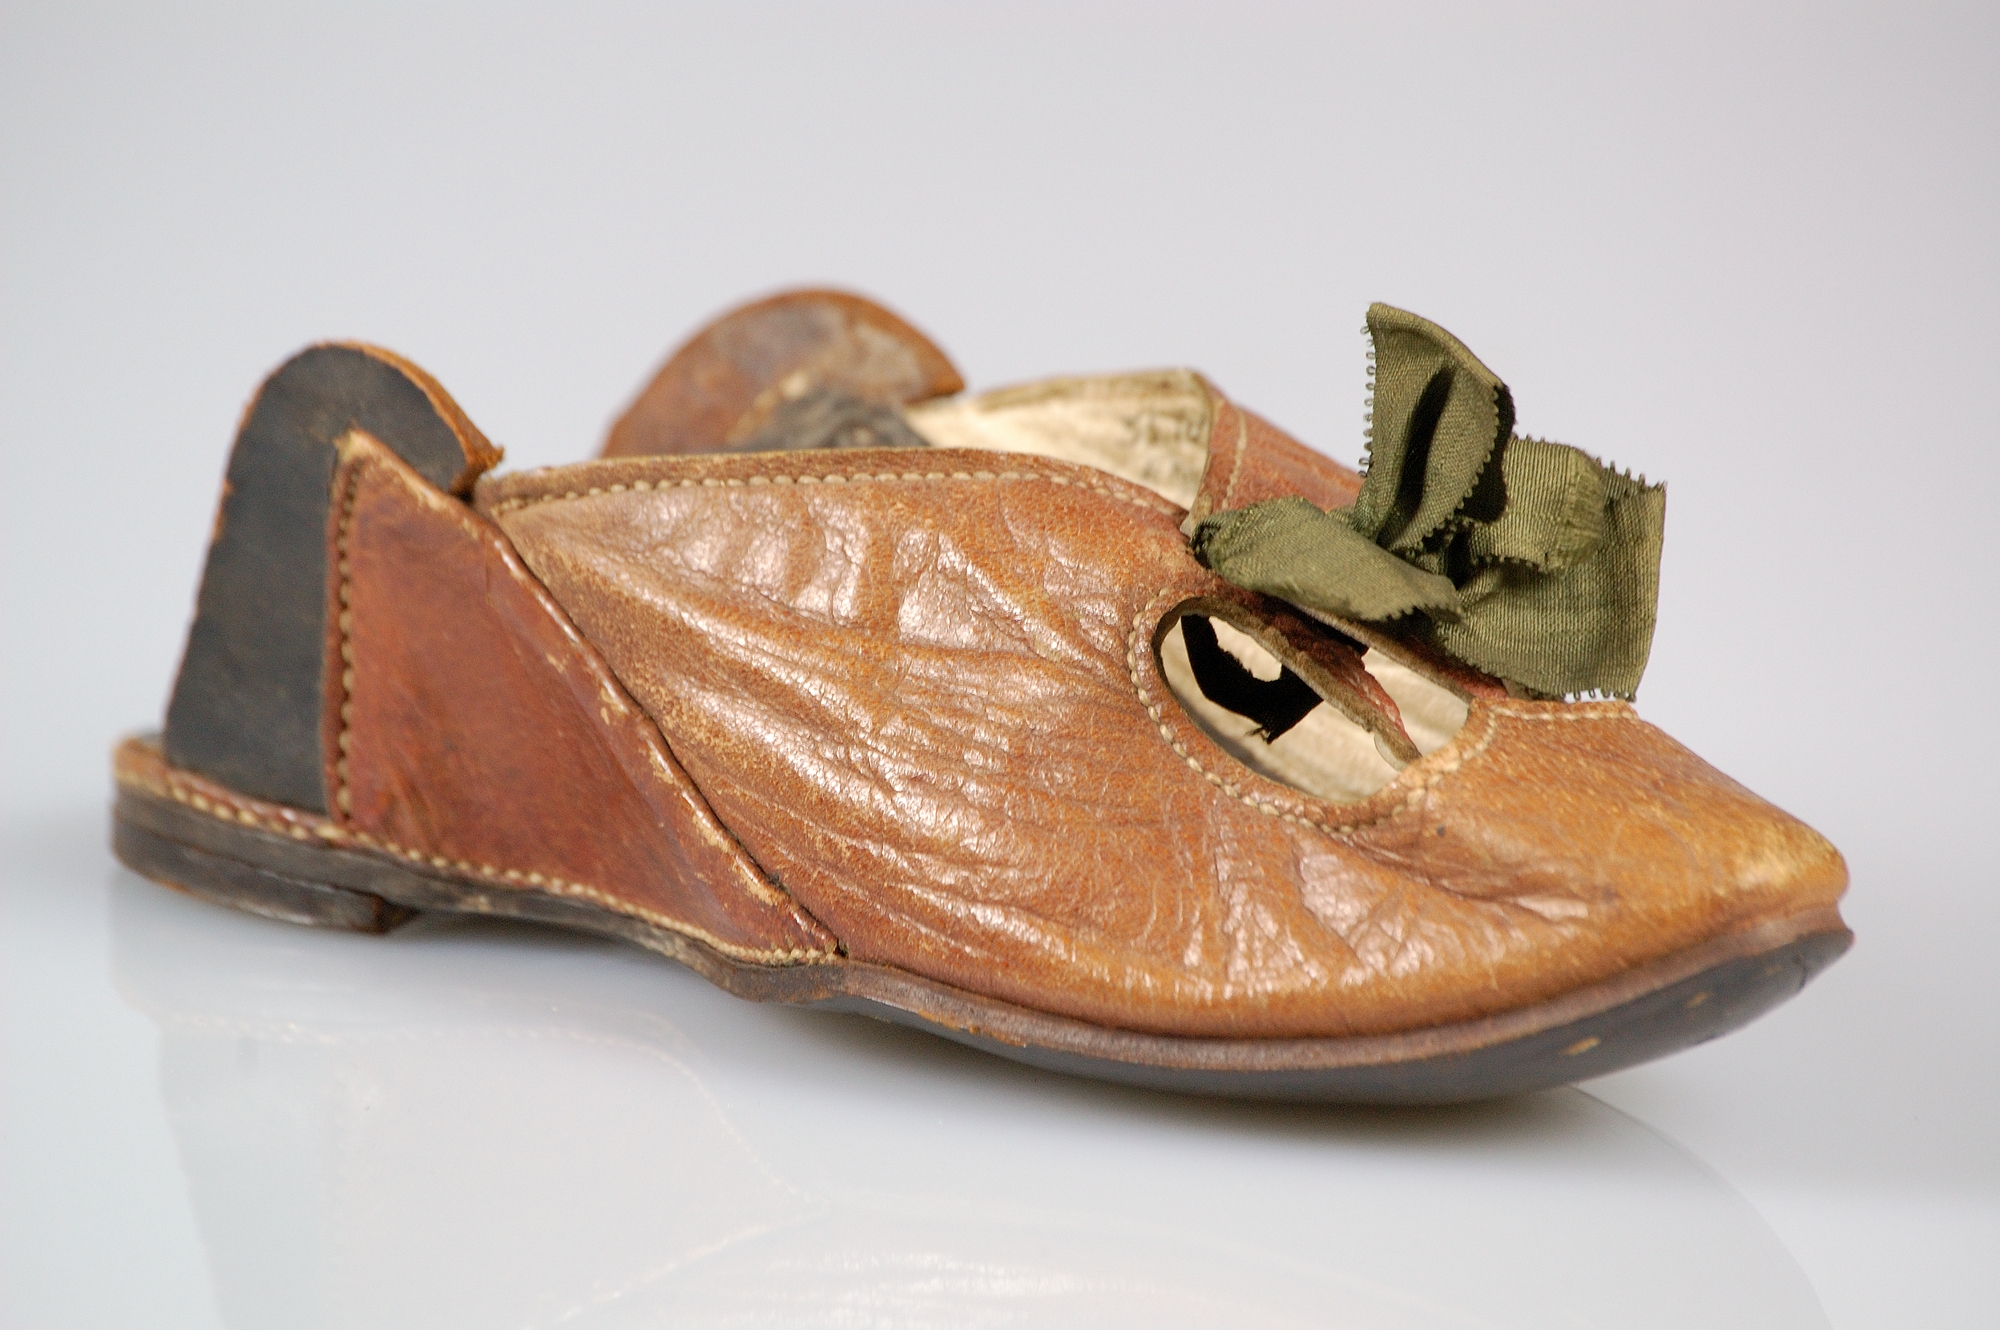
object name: patten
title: Pattens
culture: british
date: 1701-1733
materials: leather